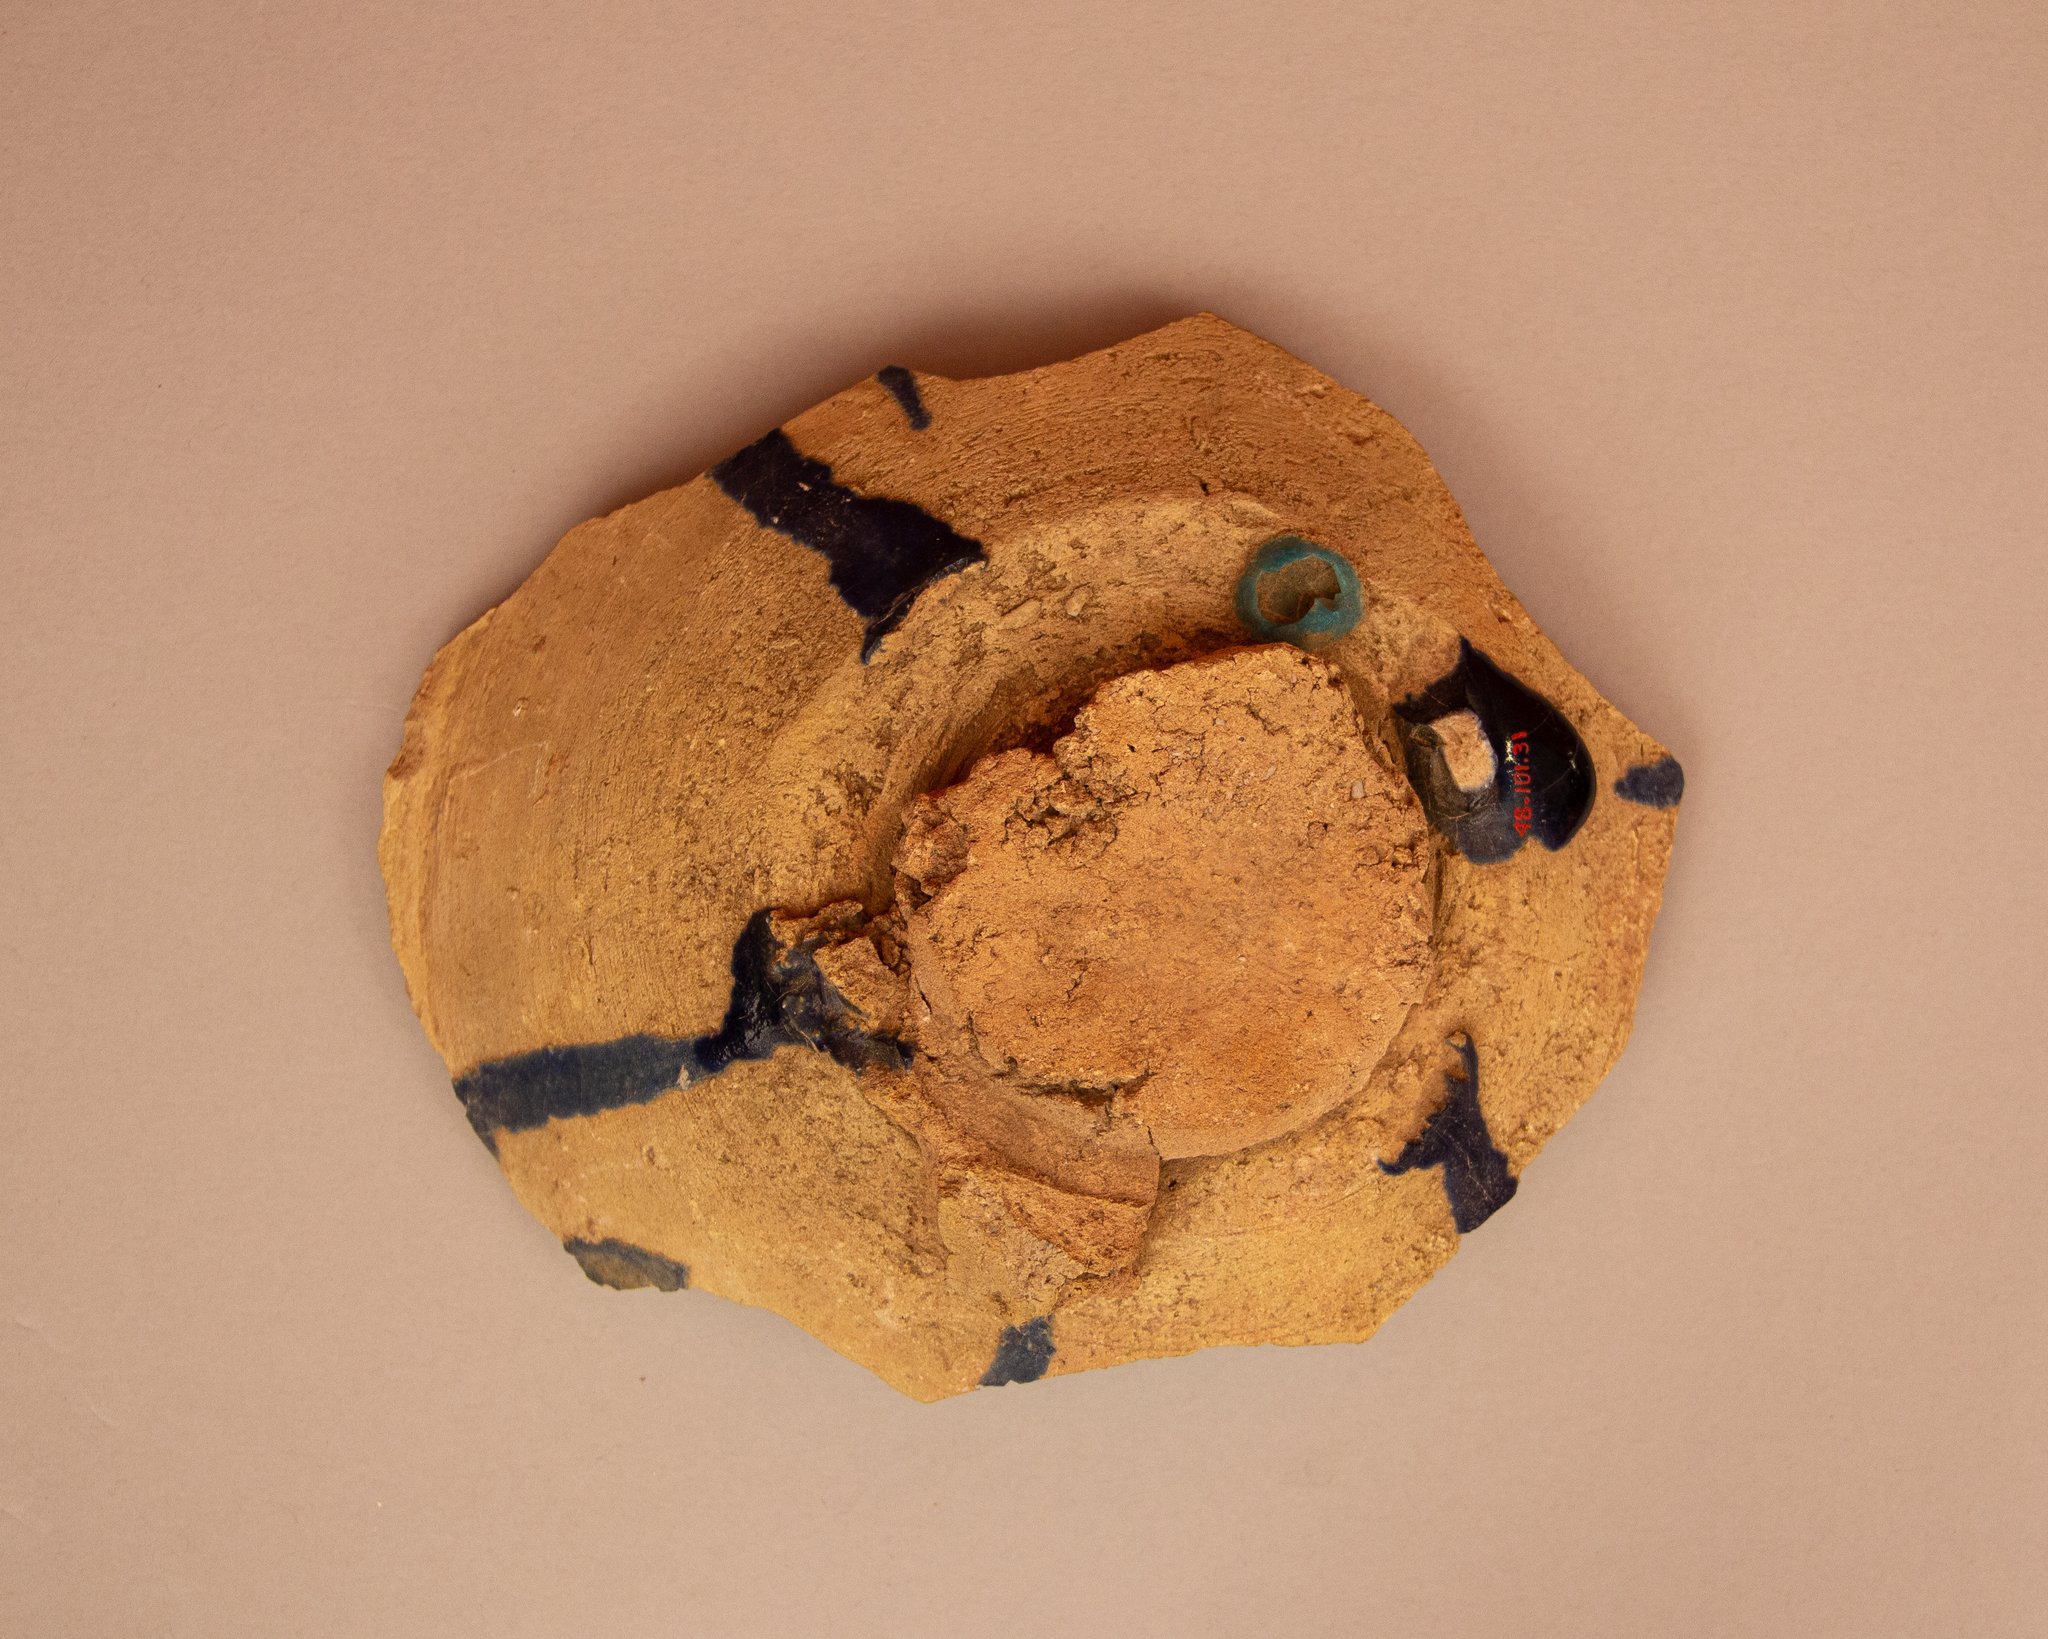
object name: fragment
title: Ceramic Fragment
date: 1001-1200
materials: cobalt, copper, earthenware, glaze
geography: iran